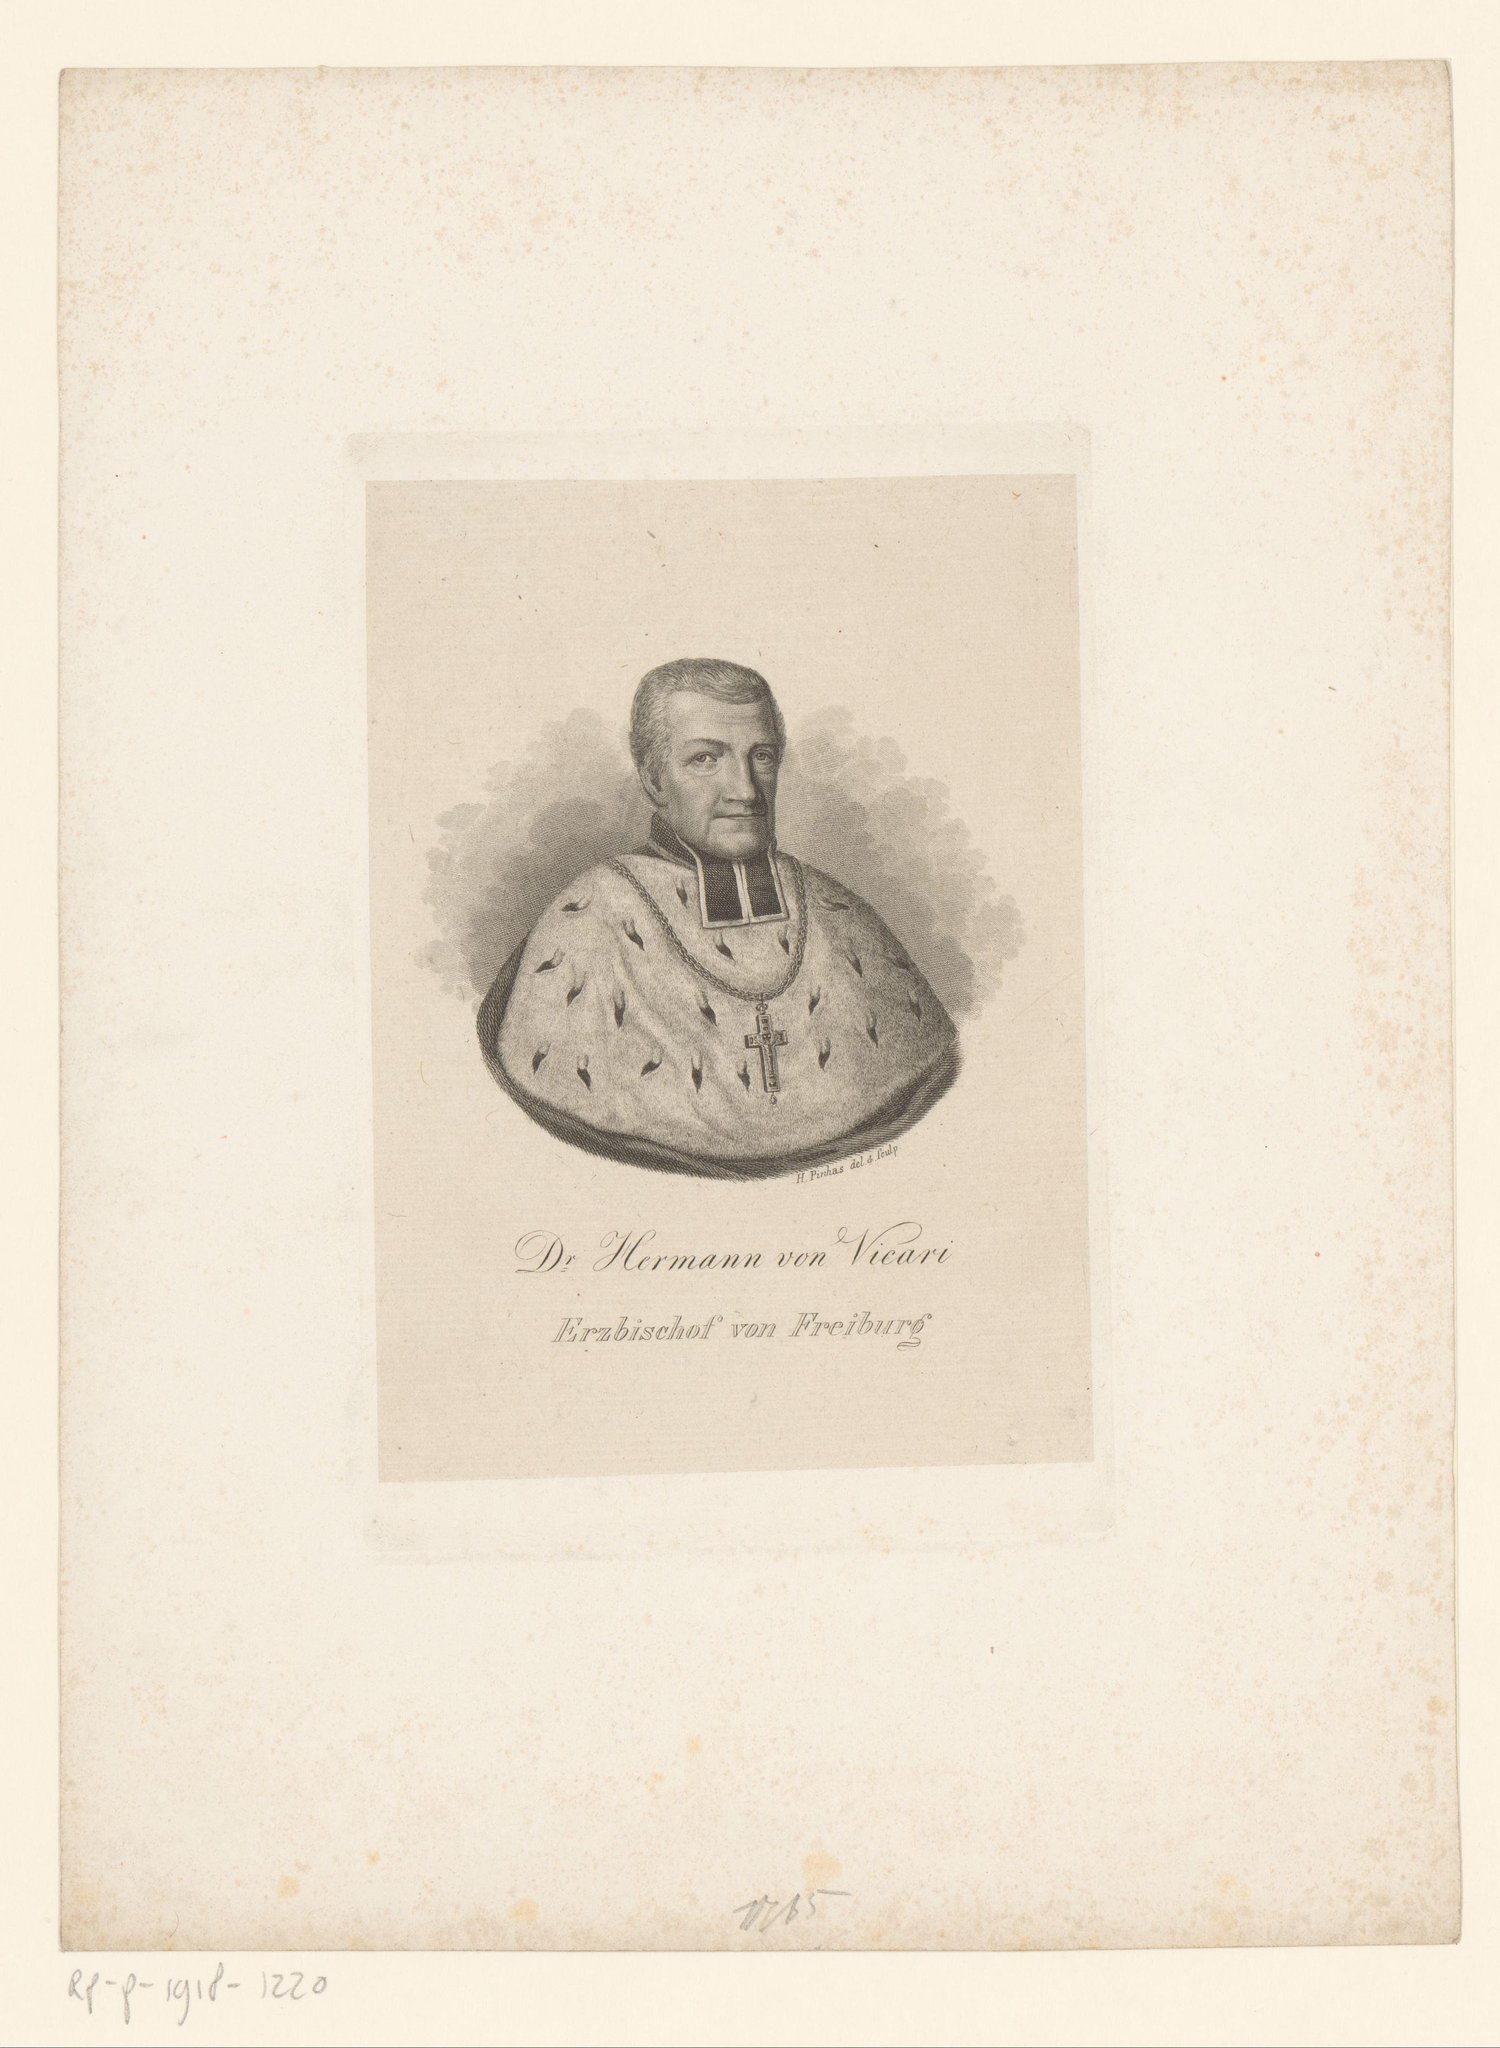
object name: print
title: Portret van Hermann von Vicari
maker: hermann hirsch pinhas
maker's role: print maker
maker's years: 1795-1844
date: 1805-1844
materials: paper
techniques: engraving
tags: historical persons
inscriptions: collector's mark: Lugt 2228